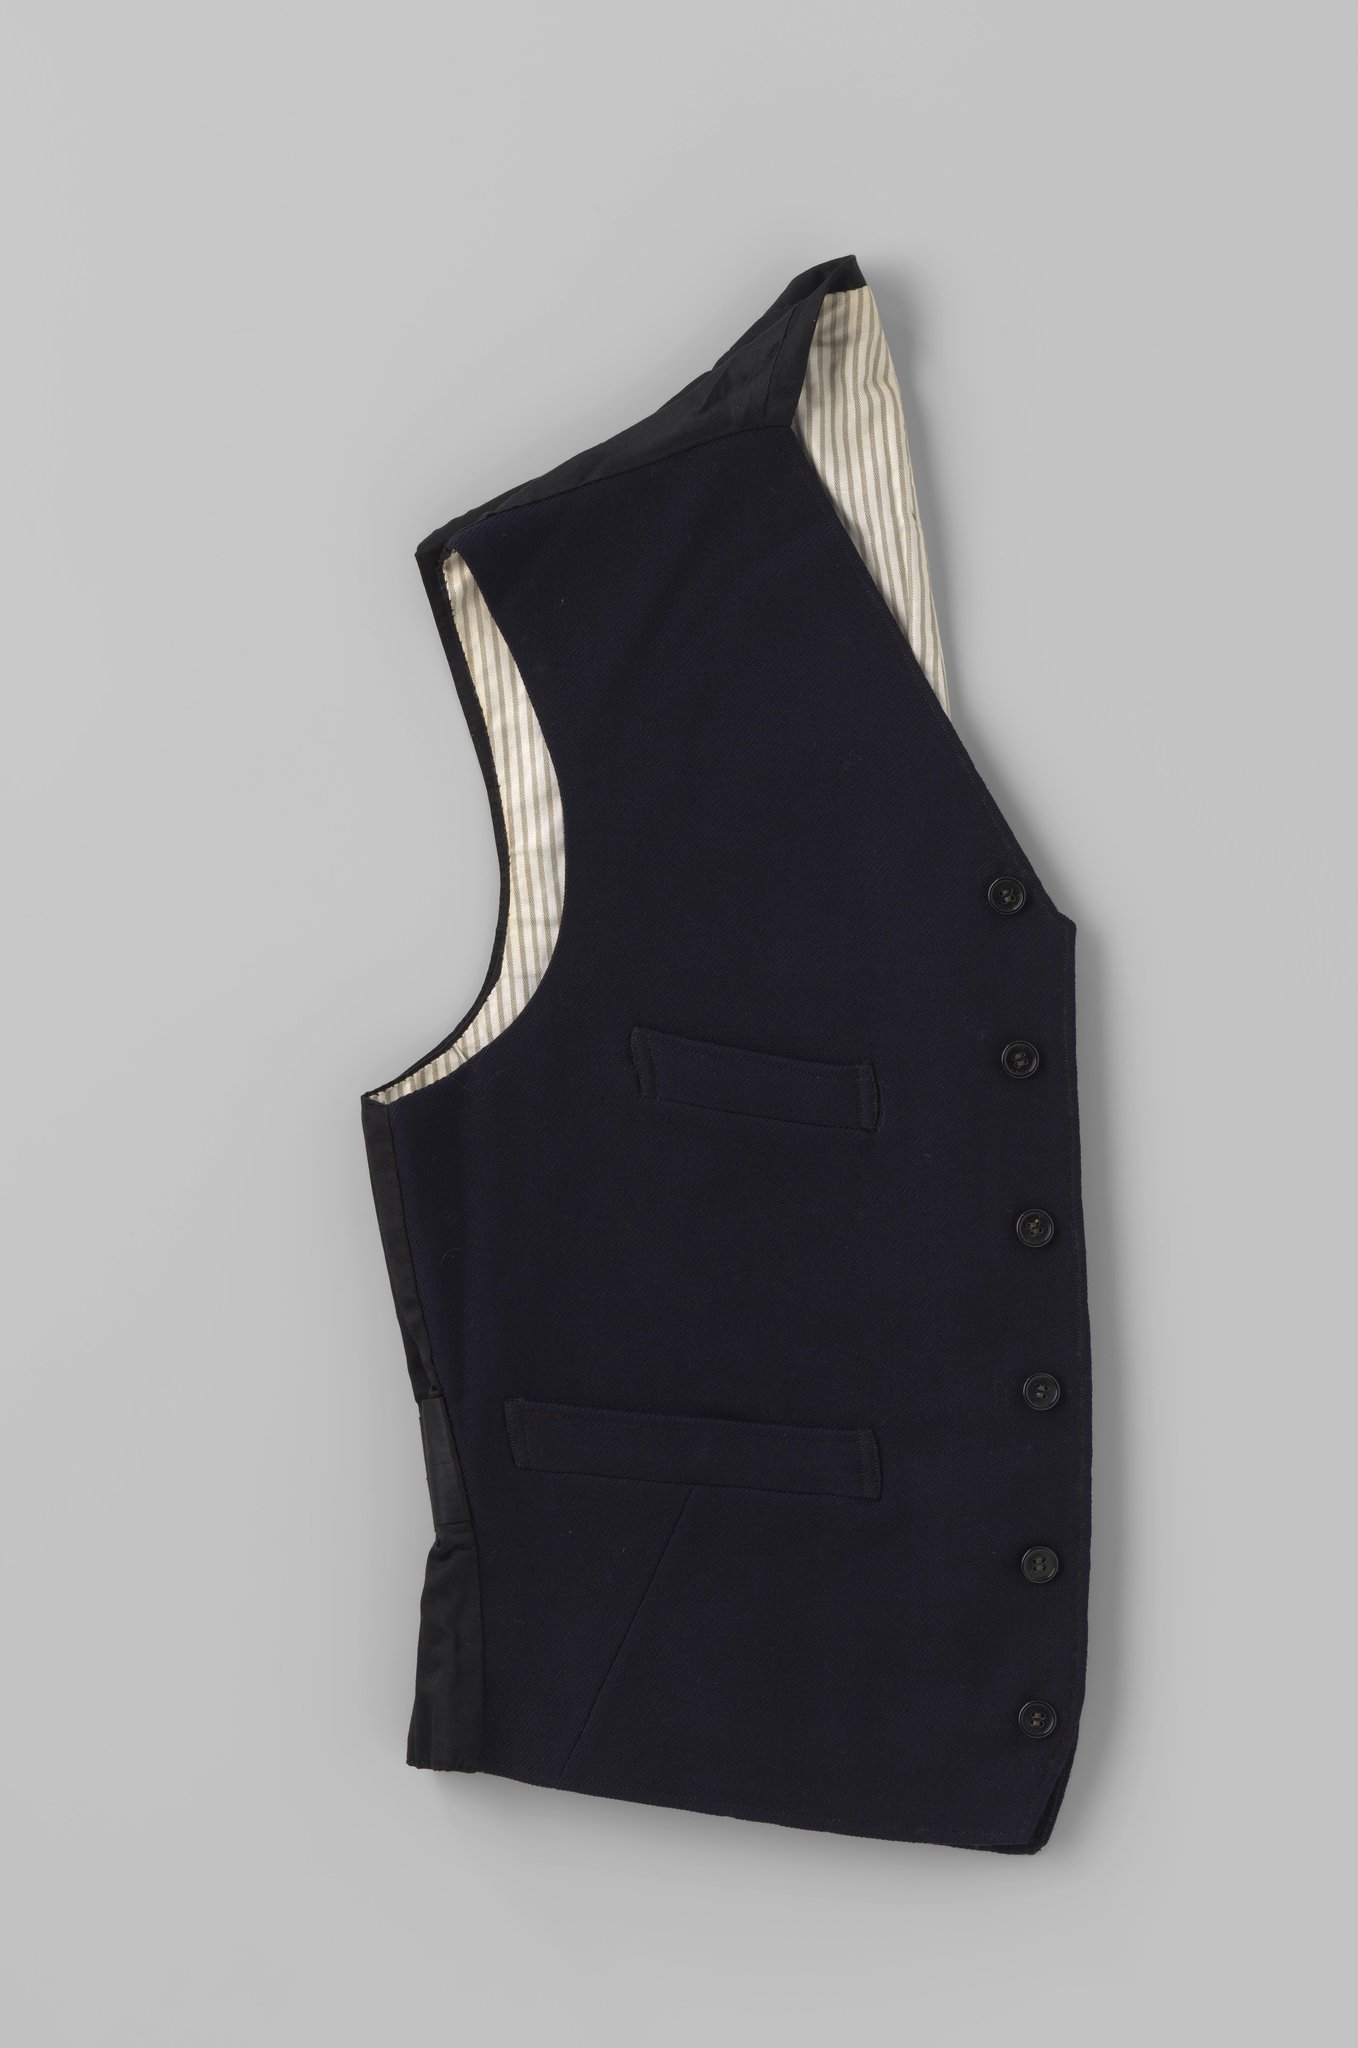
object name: vest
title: Heren- of livreivest van donkerblauwe wol in keperbinding geweven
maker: Anonymous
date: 1910-1920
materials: wool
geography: the hague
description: Heren- of livreivest van donkerblauwe wol in keperbinding geweven. Vest met hoge V-hals. Onderaan zijn de panden in een haast gesloten boog gesneden. Zes zwart benen knoopjes. Vier zakjes. Voering van grijs/witte gestreepte satinet, waarin links een binnenzak, met benen knoop te sluiten.